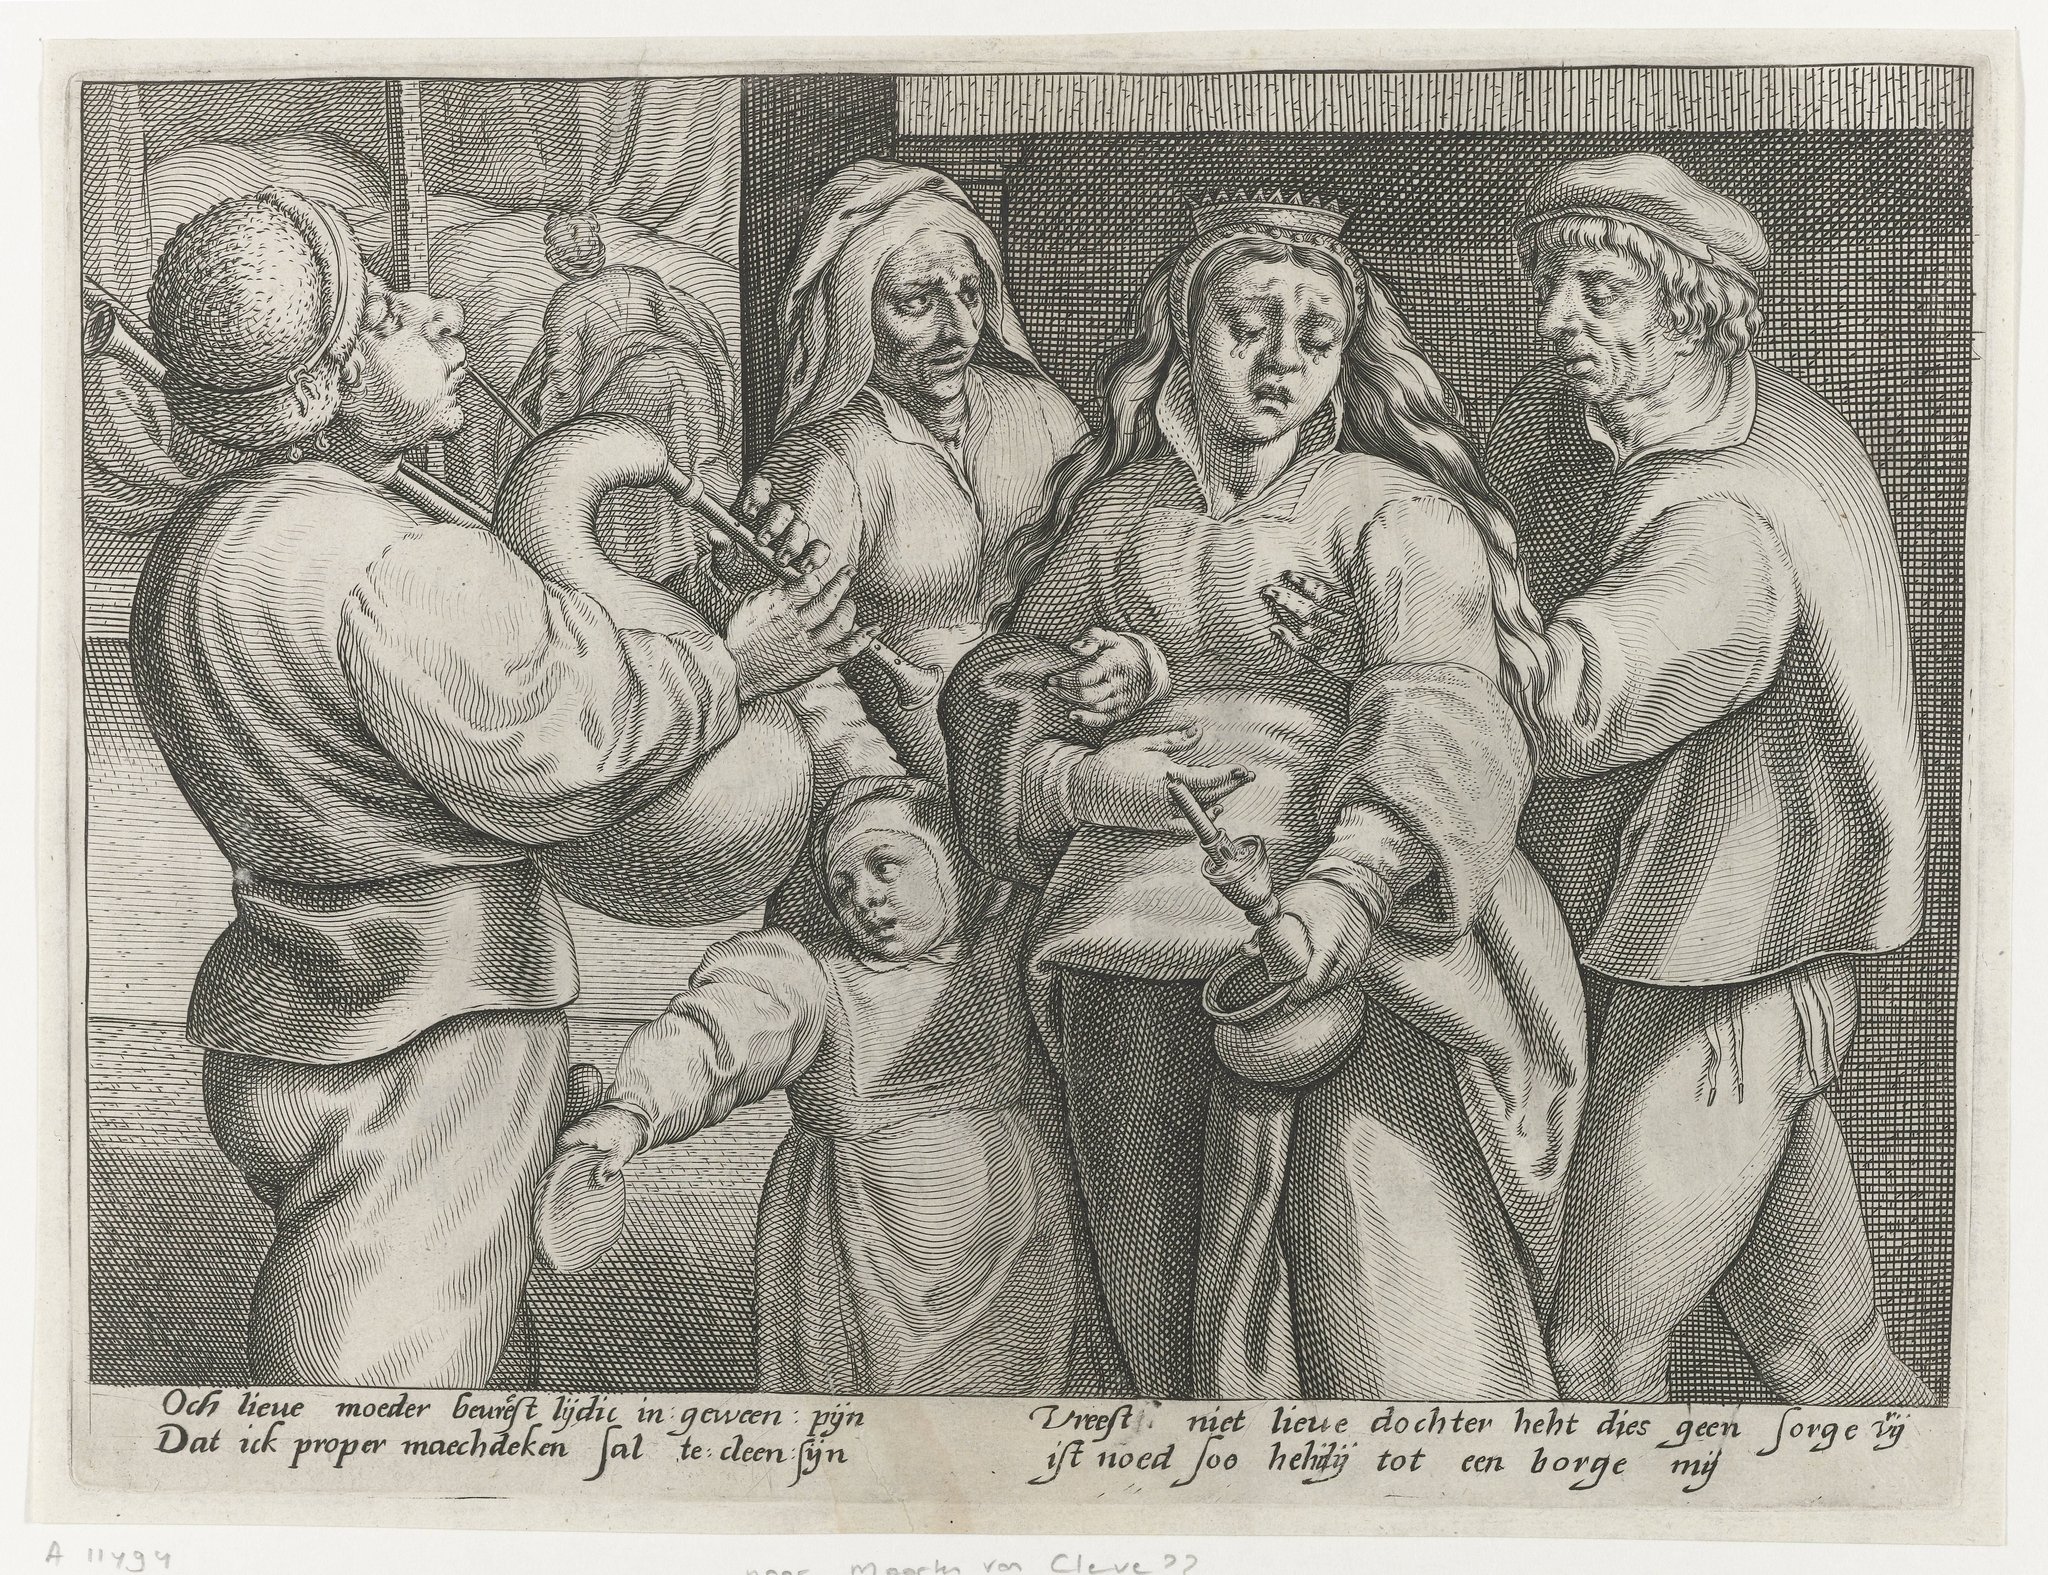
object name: print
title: Angstige bruid wordt naar het huwelijksbed geleid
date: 1537-1600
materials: paper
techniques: engraving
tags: one person playing wind instrument, bagpipe, musette, leading the bride to bed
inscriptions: collector's mark: Lugt 2228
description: Een huilende bruid wordt door haar moeder en haar man naar het huwelijksbed geleid, terwijl een boer op de doedelzak speelt. Op de achtergrond maakt een vrouw het bed op. Onder de voorstelling een vierregelig vers.